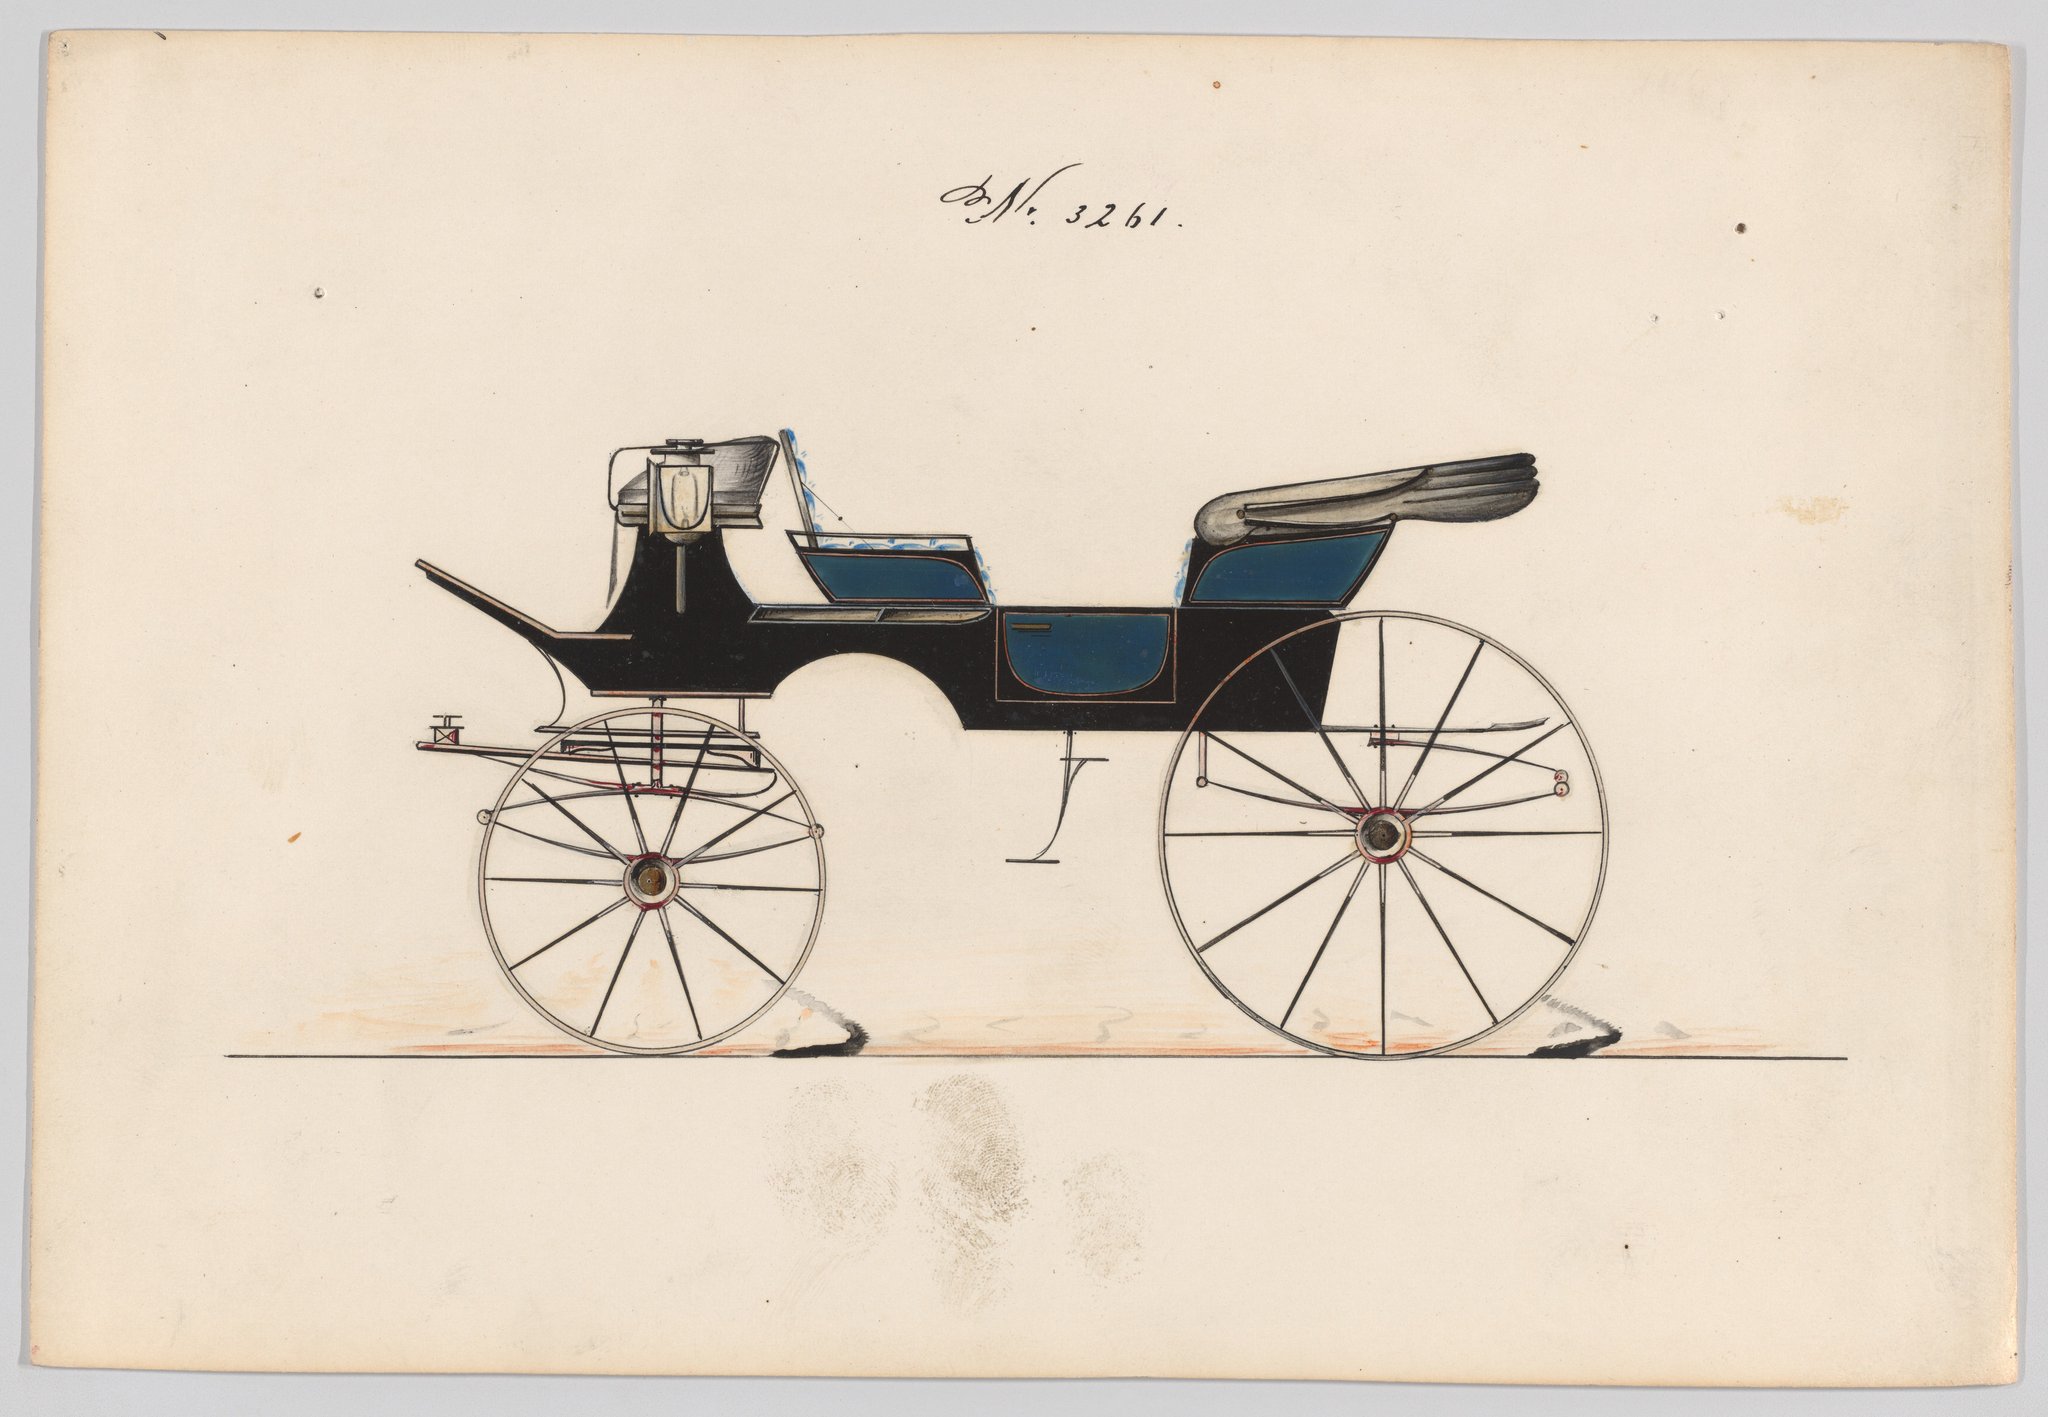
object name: drawing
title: Drag # 3261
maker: brewster & co.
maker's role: manufacturer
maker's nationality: american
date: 1876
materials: gouache, gum arabic, ink, watercolor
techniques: pen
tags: carriages